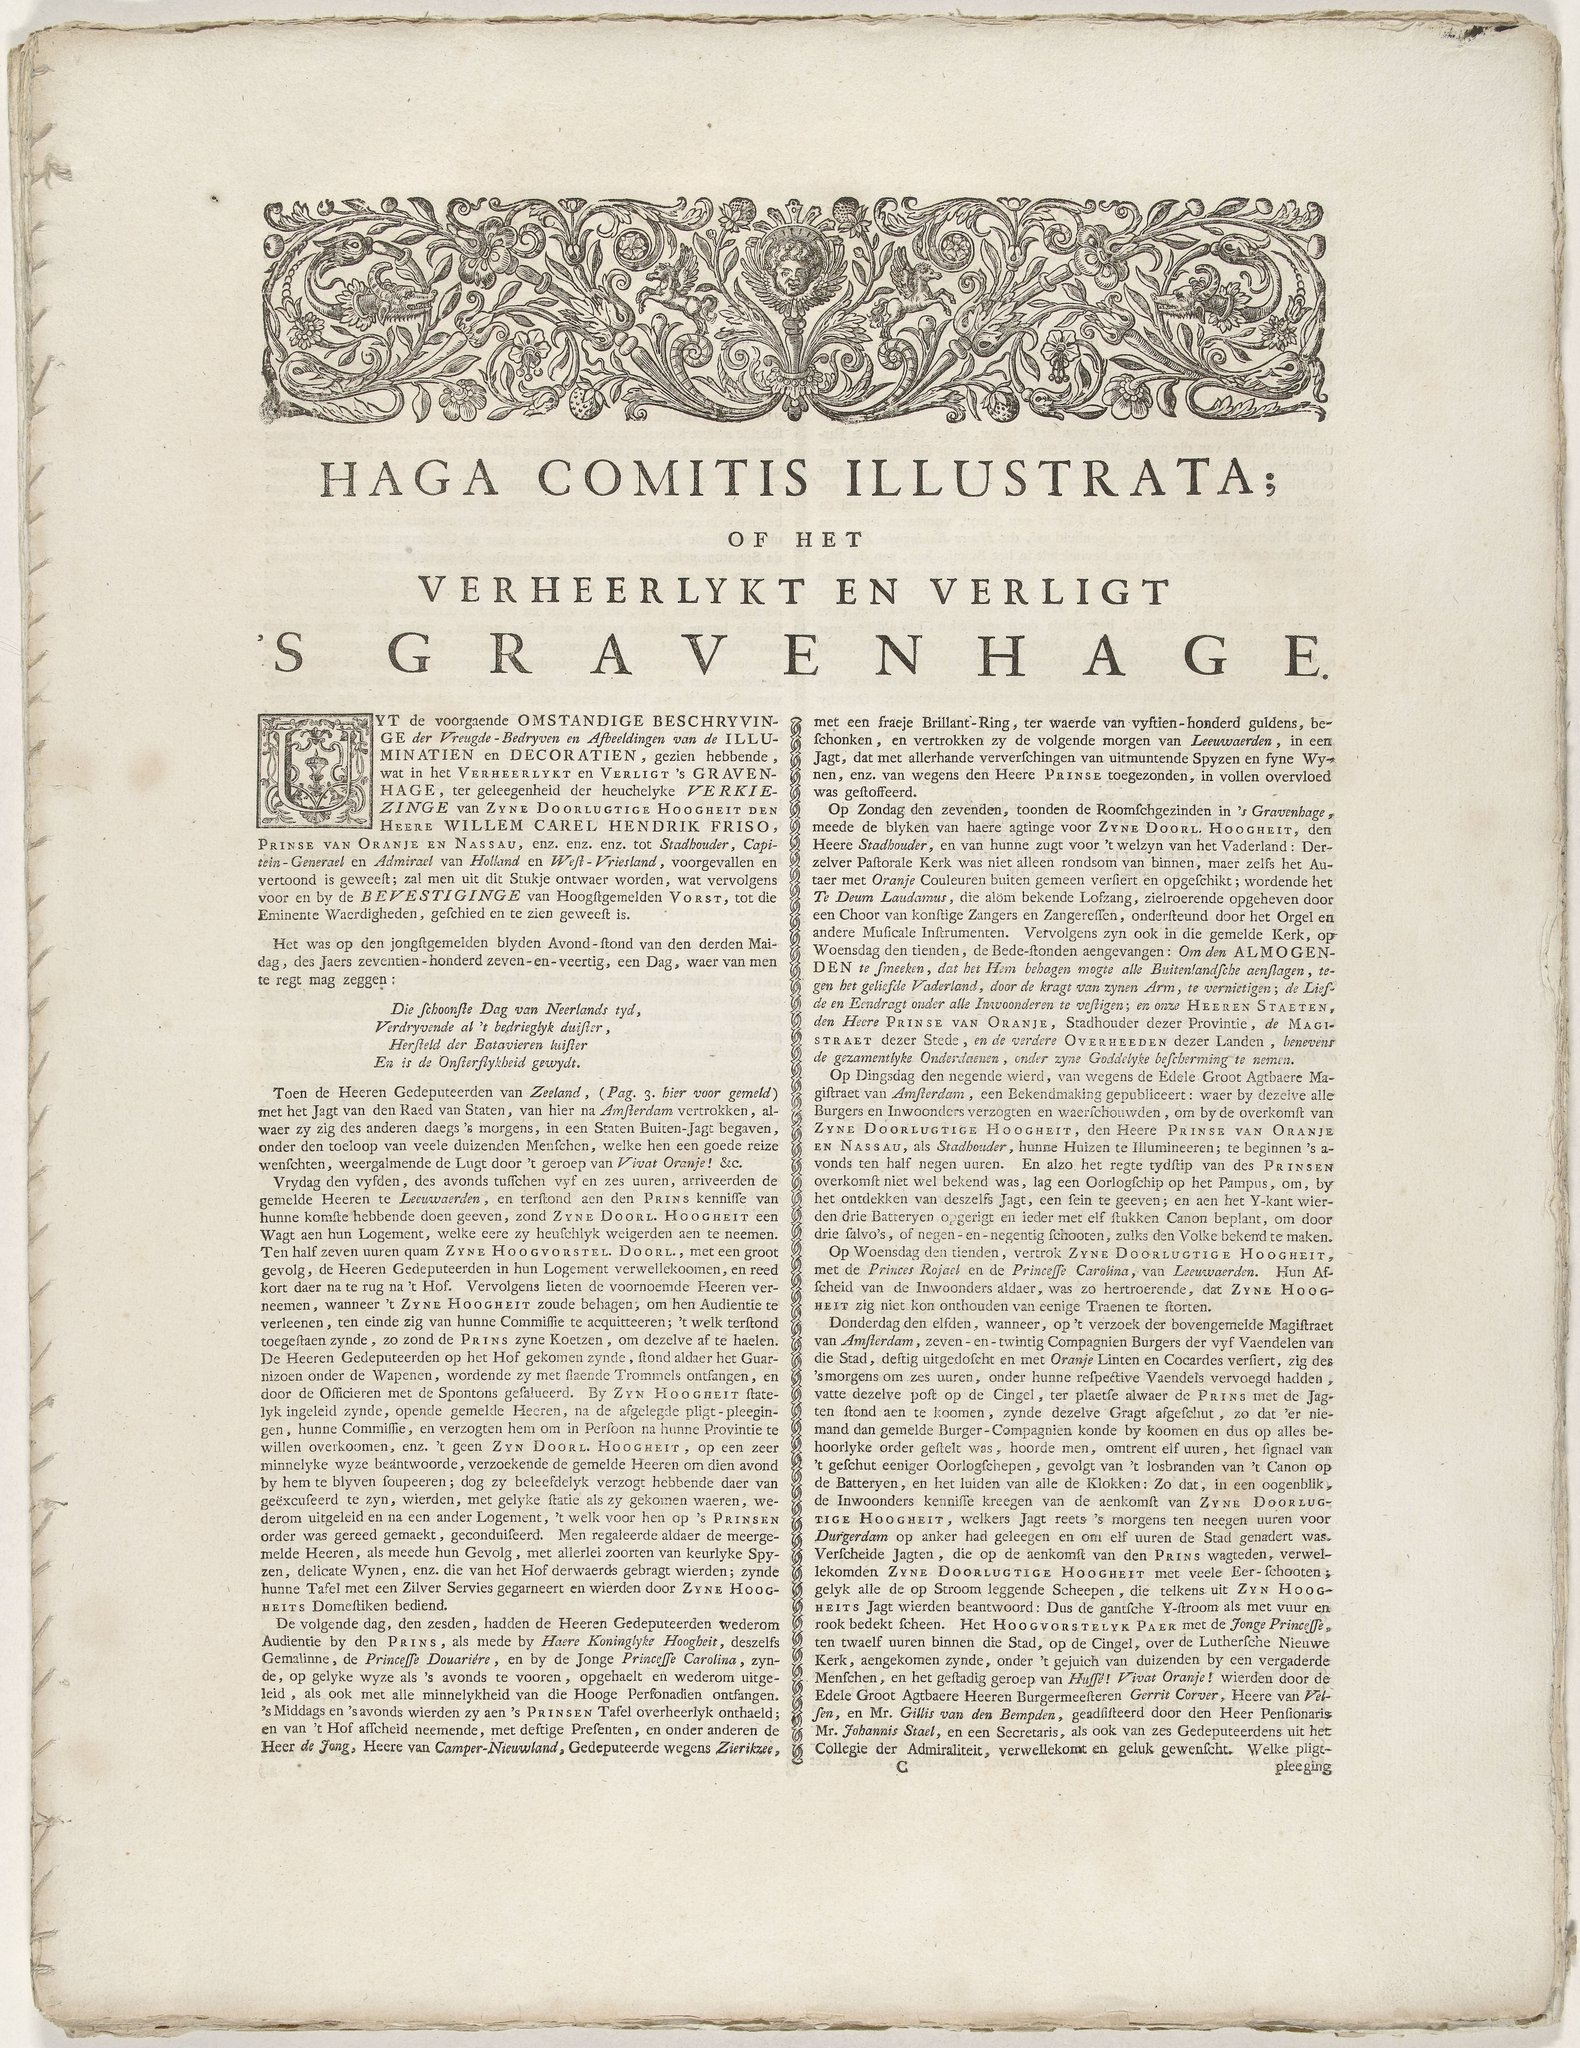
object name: print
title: Haga comitis illustrata; of het verheerlykt en verligt 's Gravenhage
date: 1751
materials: paper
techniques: letterpress printing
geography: northern netherlands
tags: the hague, willem iv (prins van oranje-nassau)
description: Negende tekstblad met tekst in twee kolommen en bovenaan een ornamentaal vignet. Los blad oorspronkelijk onderdeel van het plaatwerk Haga comitis illustrata uit 1751 met de versieringen opgesteld te Den Haag tijdens de feestelijkheden rond de installatie van prins Willem IV als stadhouder van Holland en West-Friesland op 3 en 15 mei 1747.